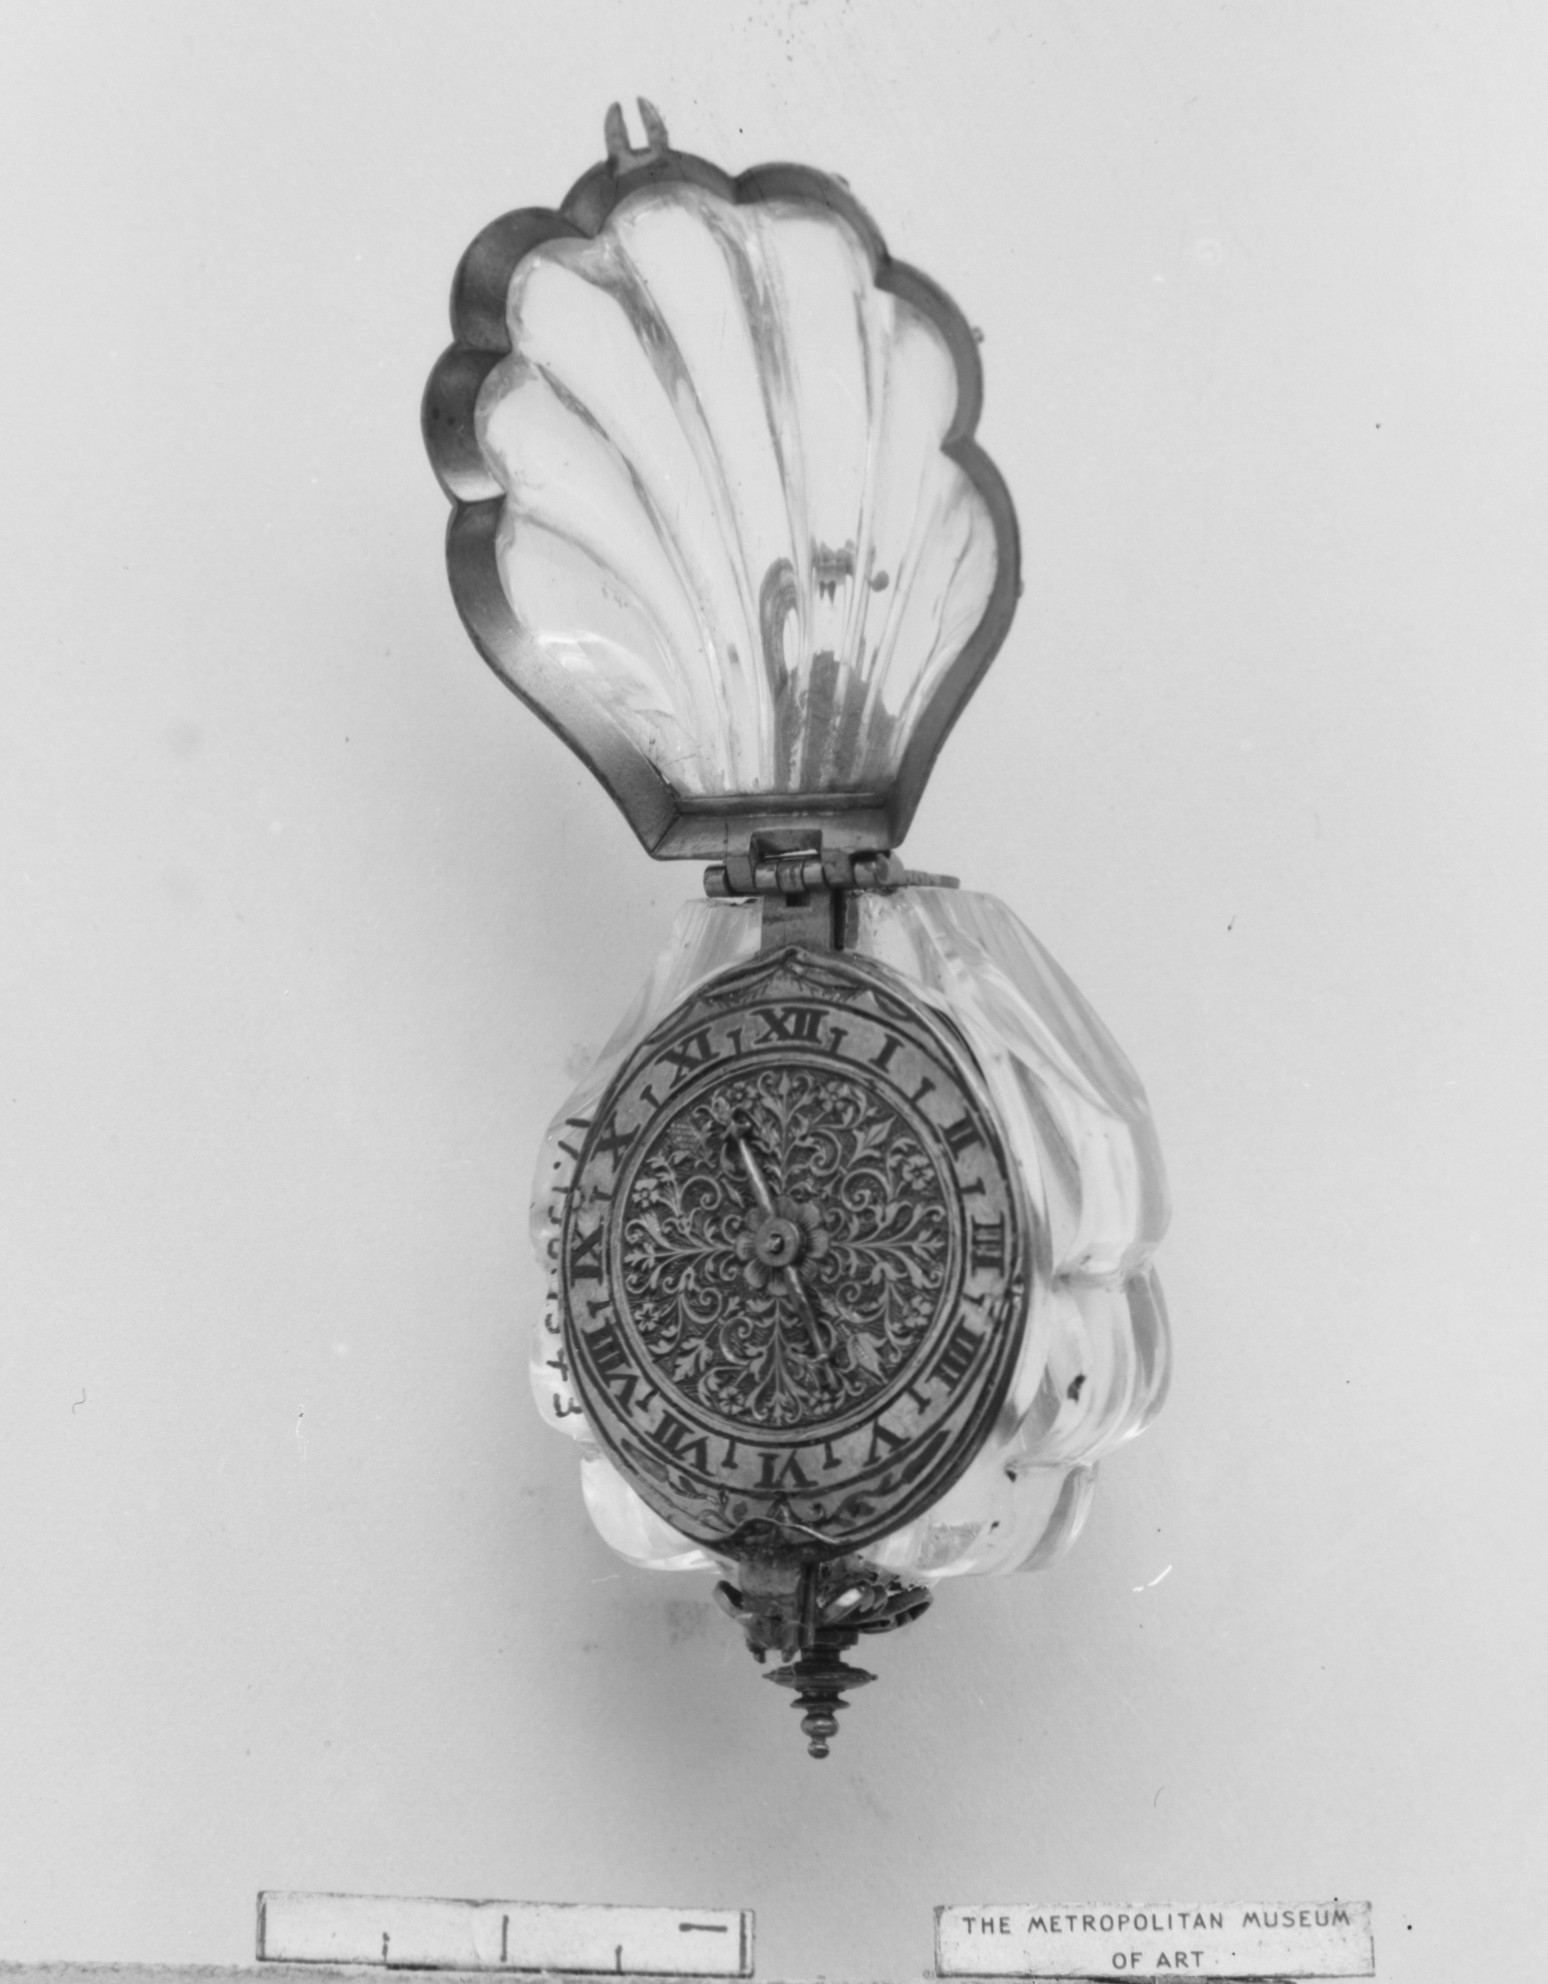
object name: watch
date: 1650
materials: metal, quartz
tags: shells